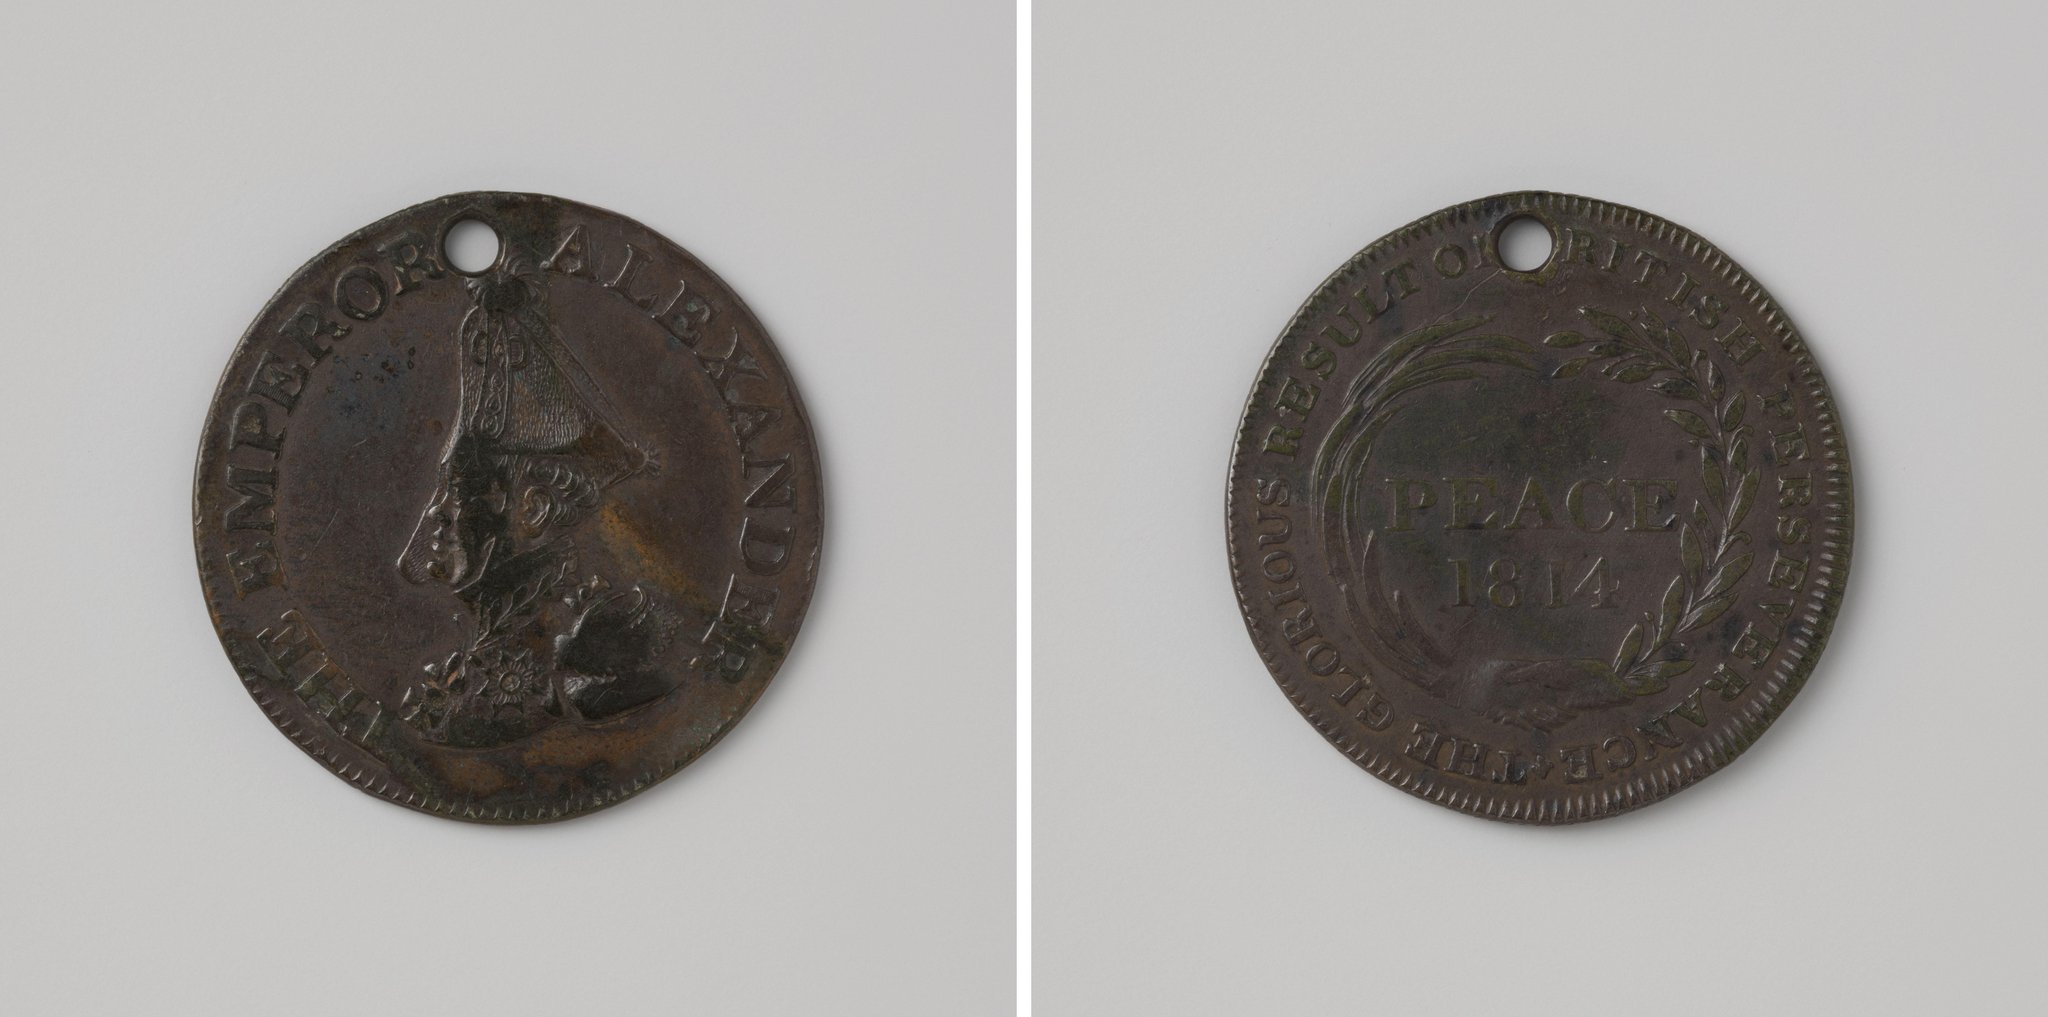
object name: jeton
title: Eerste vrede van Parijs tussen Frankrijk en de geallieerden, ter ere van Alexander I, tsaar van Rusland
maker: Anonymous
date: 1814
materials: copper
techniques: striking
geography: england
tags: alexander i (tsaar van rusland), paris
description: Koperen penning met gat erin. Voorzijde: borststuk man binnen omschrift. Keerzijde: opschrift binnen krans van palm- en olijftak, die uitlopen in twee ineen geslagen handen binnen omschrift